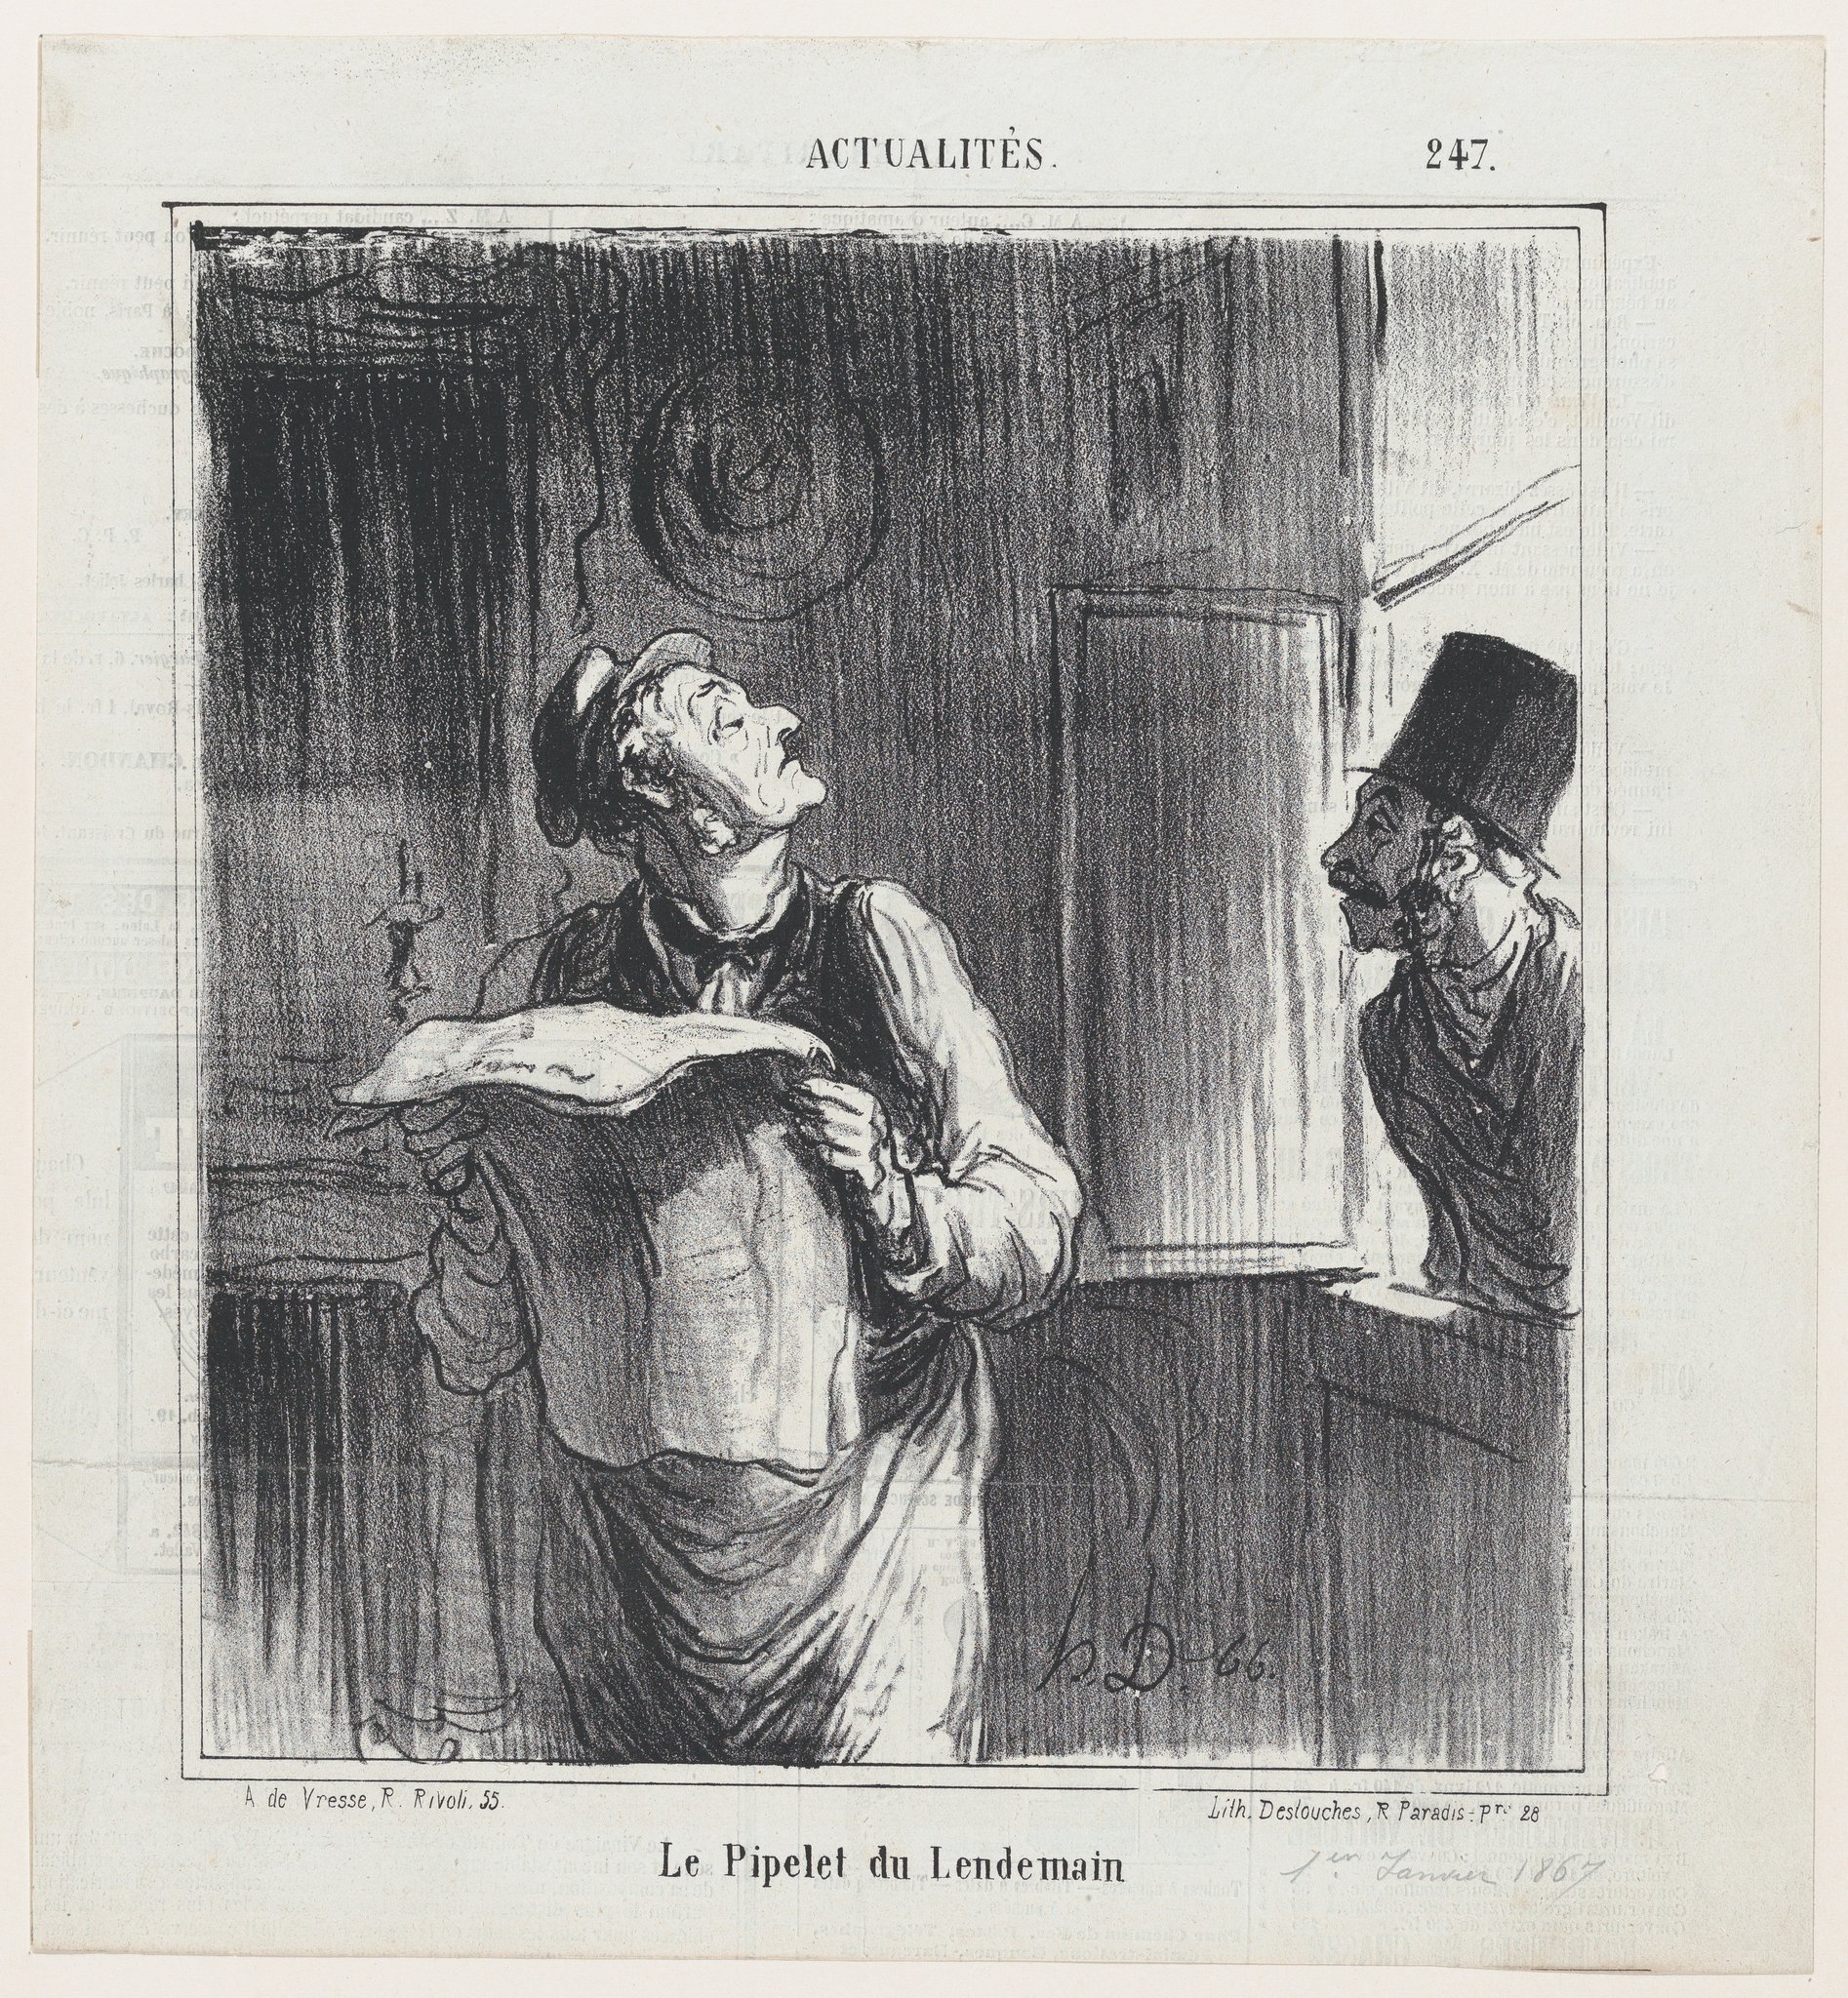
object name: print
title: The concierge the day after, from 'News of the day,' published in Le Charivari, January 1, 1867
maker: honoré daumier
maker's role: artist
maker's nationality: french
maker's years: 1808-1879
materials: paper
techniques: lithograph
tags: satire,men